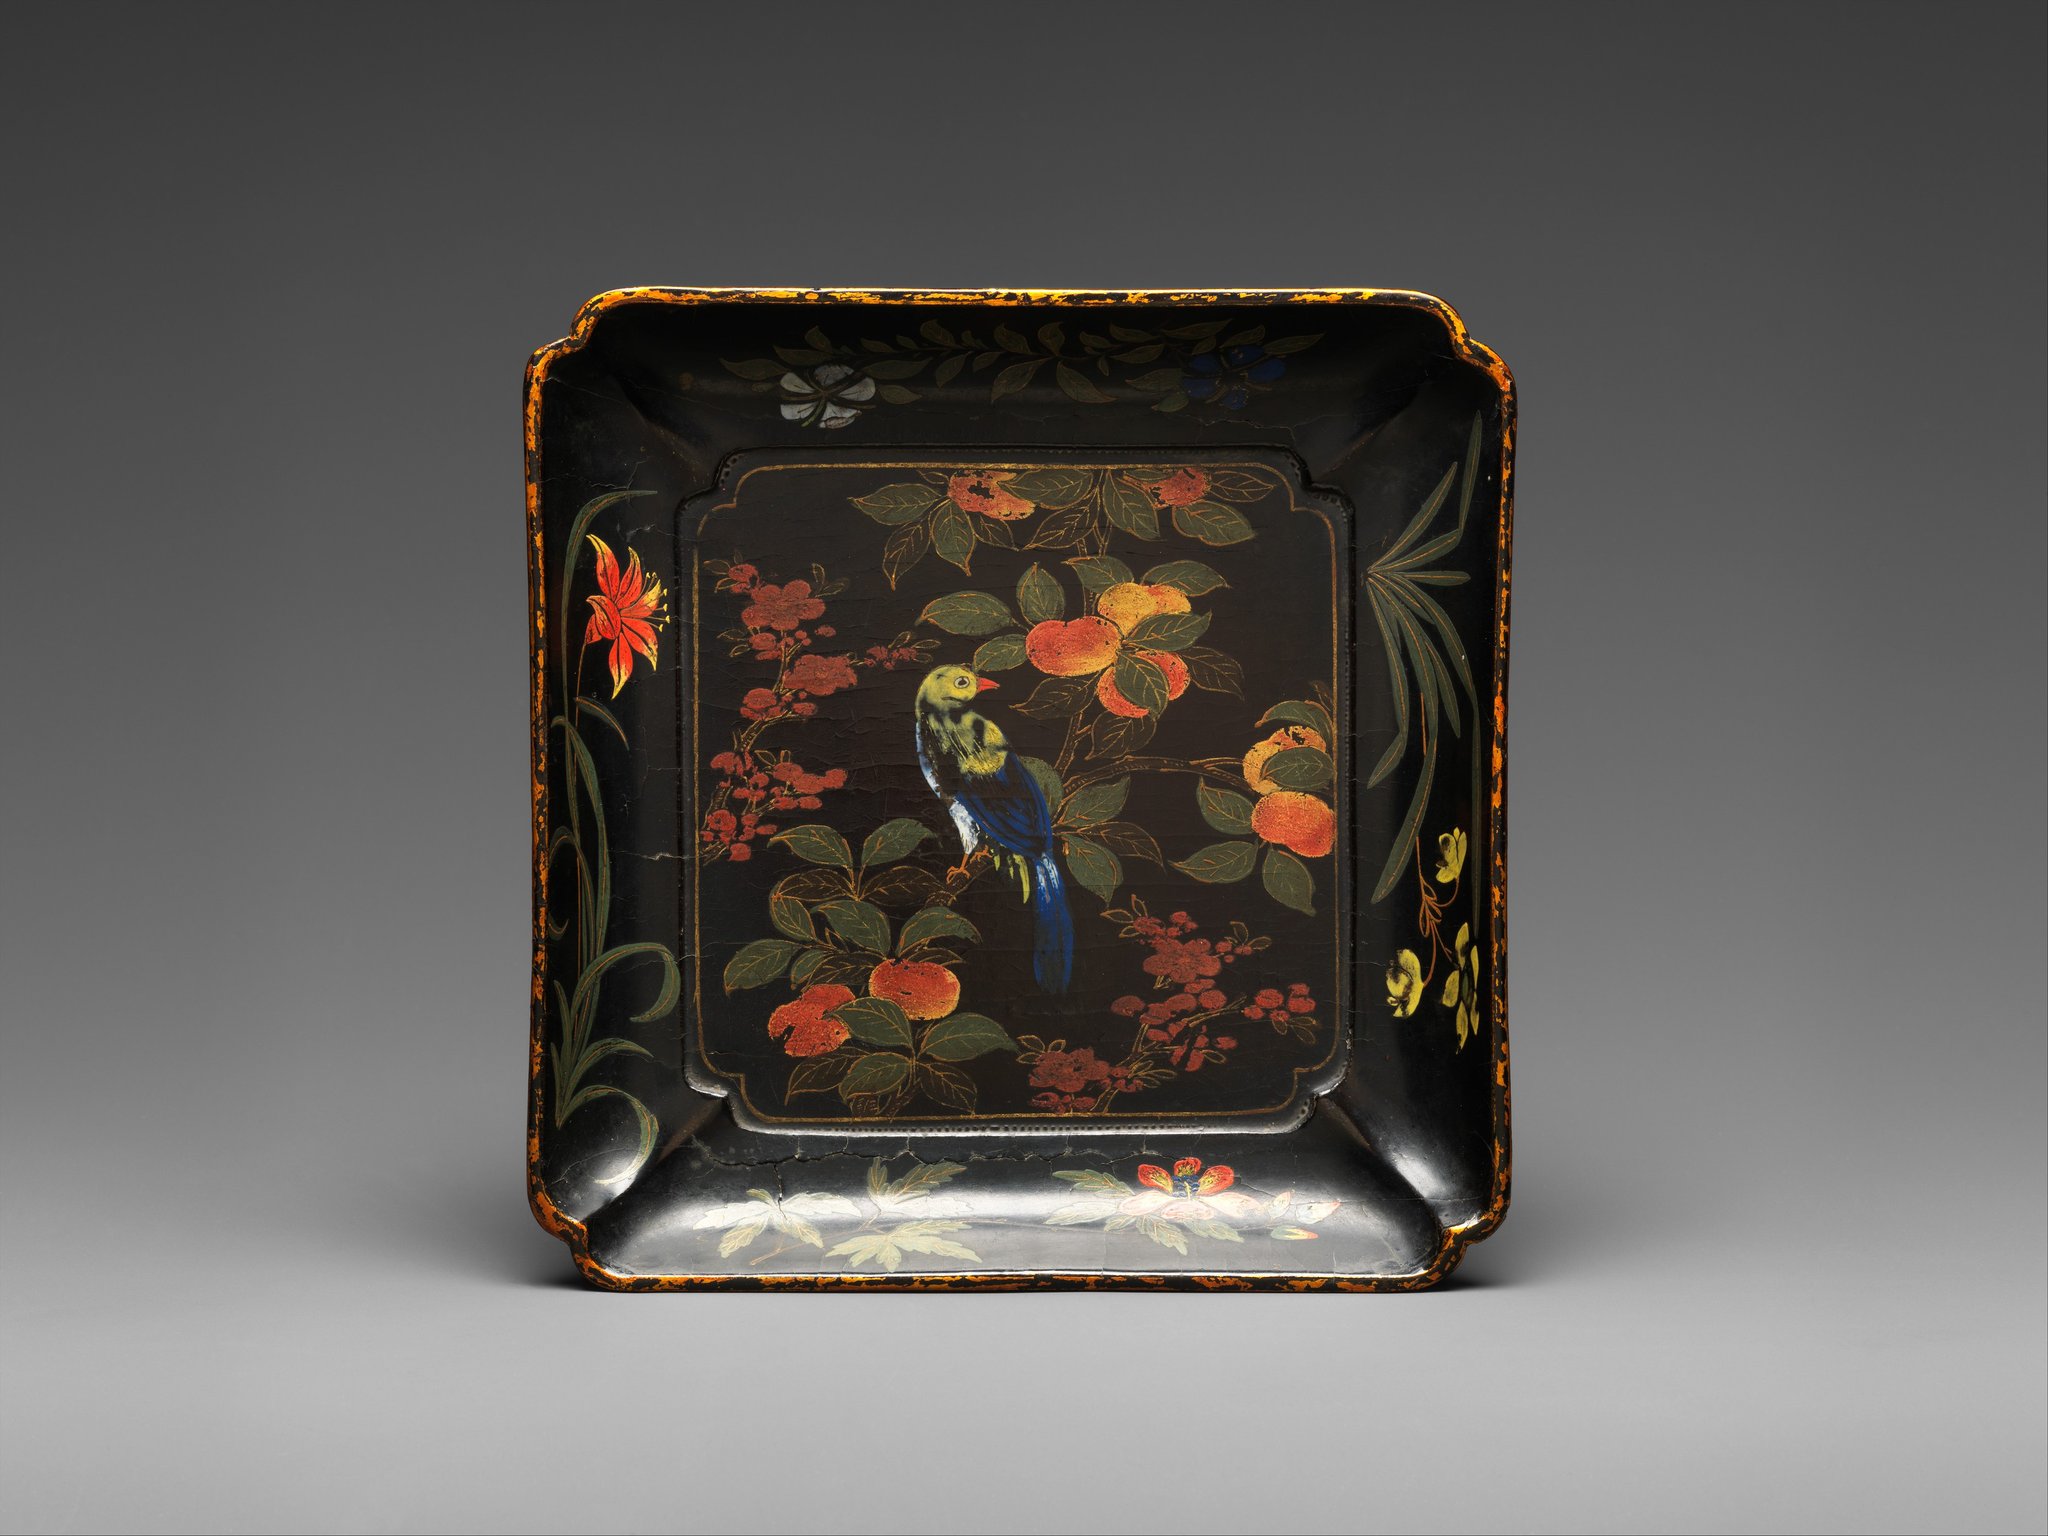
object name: dish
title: Dish with persimmons, flowers, and birds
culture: chinese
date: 1501-1600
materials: lacquer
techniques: painting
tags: birds,flowers